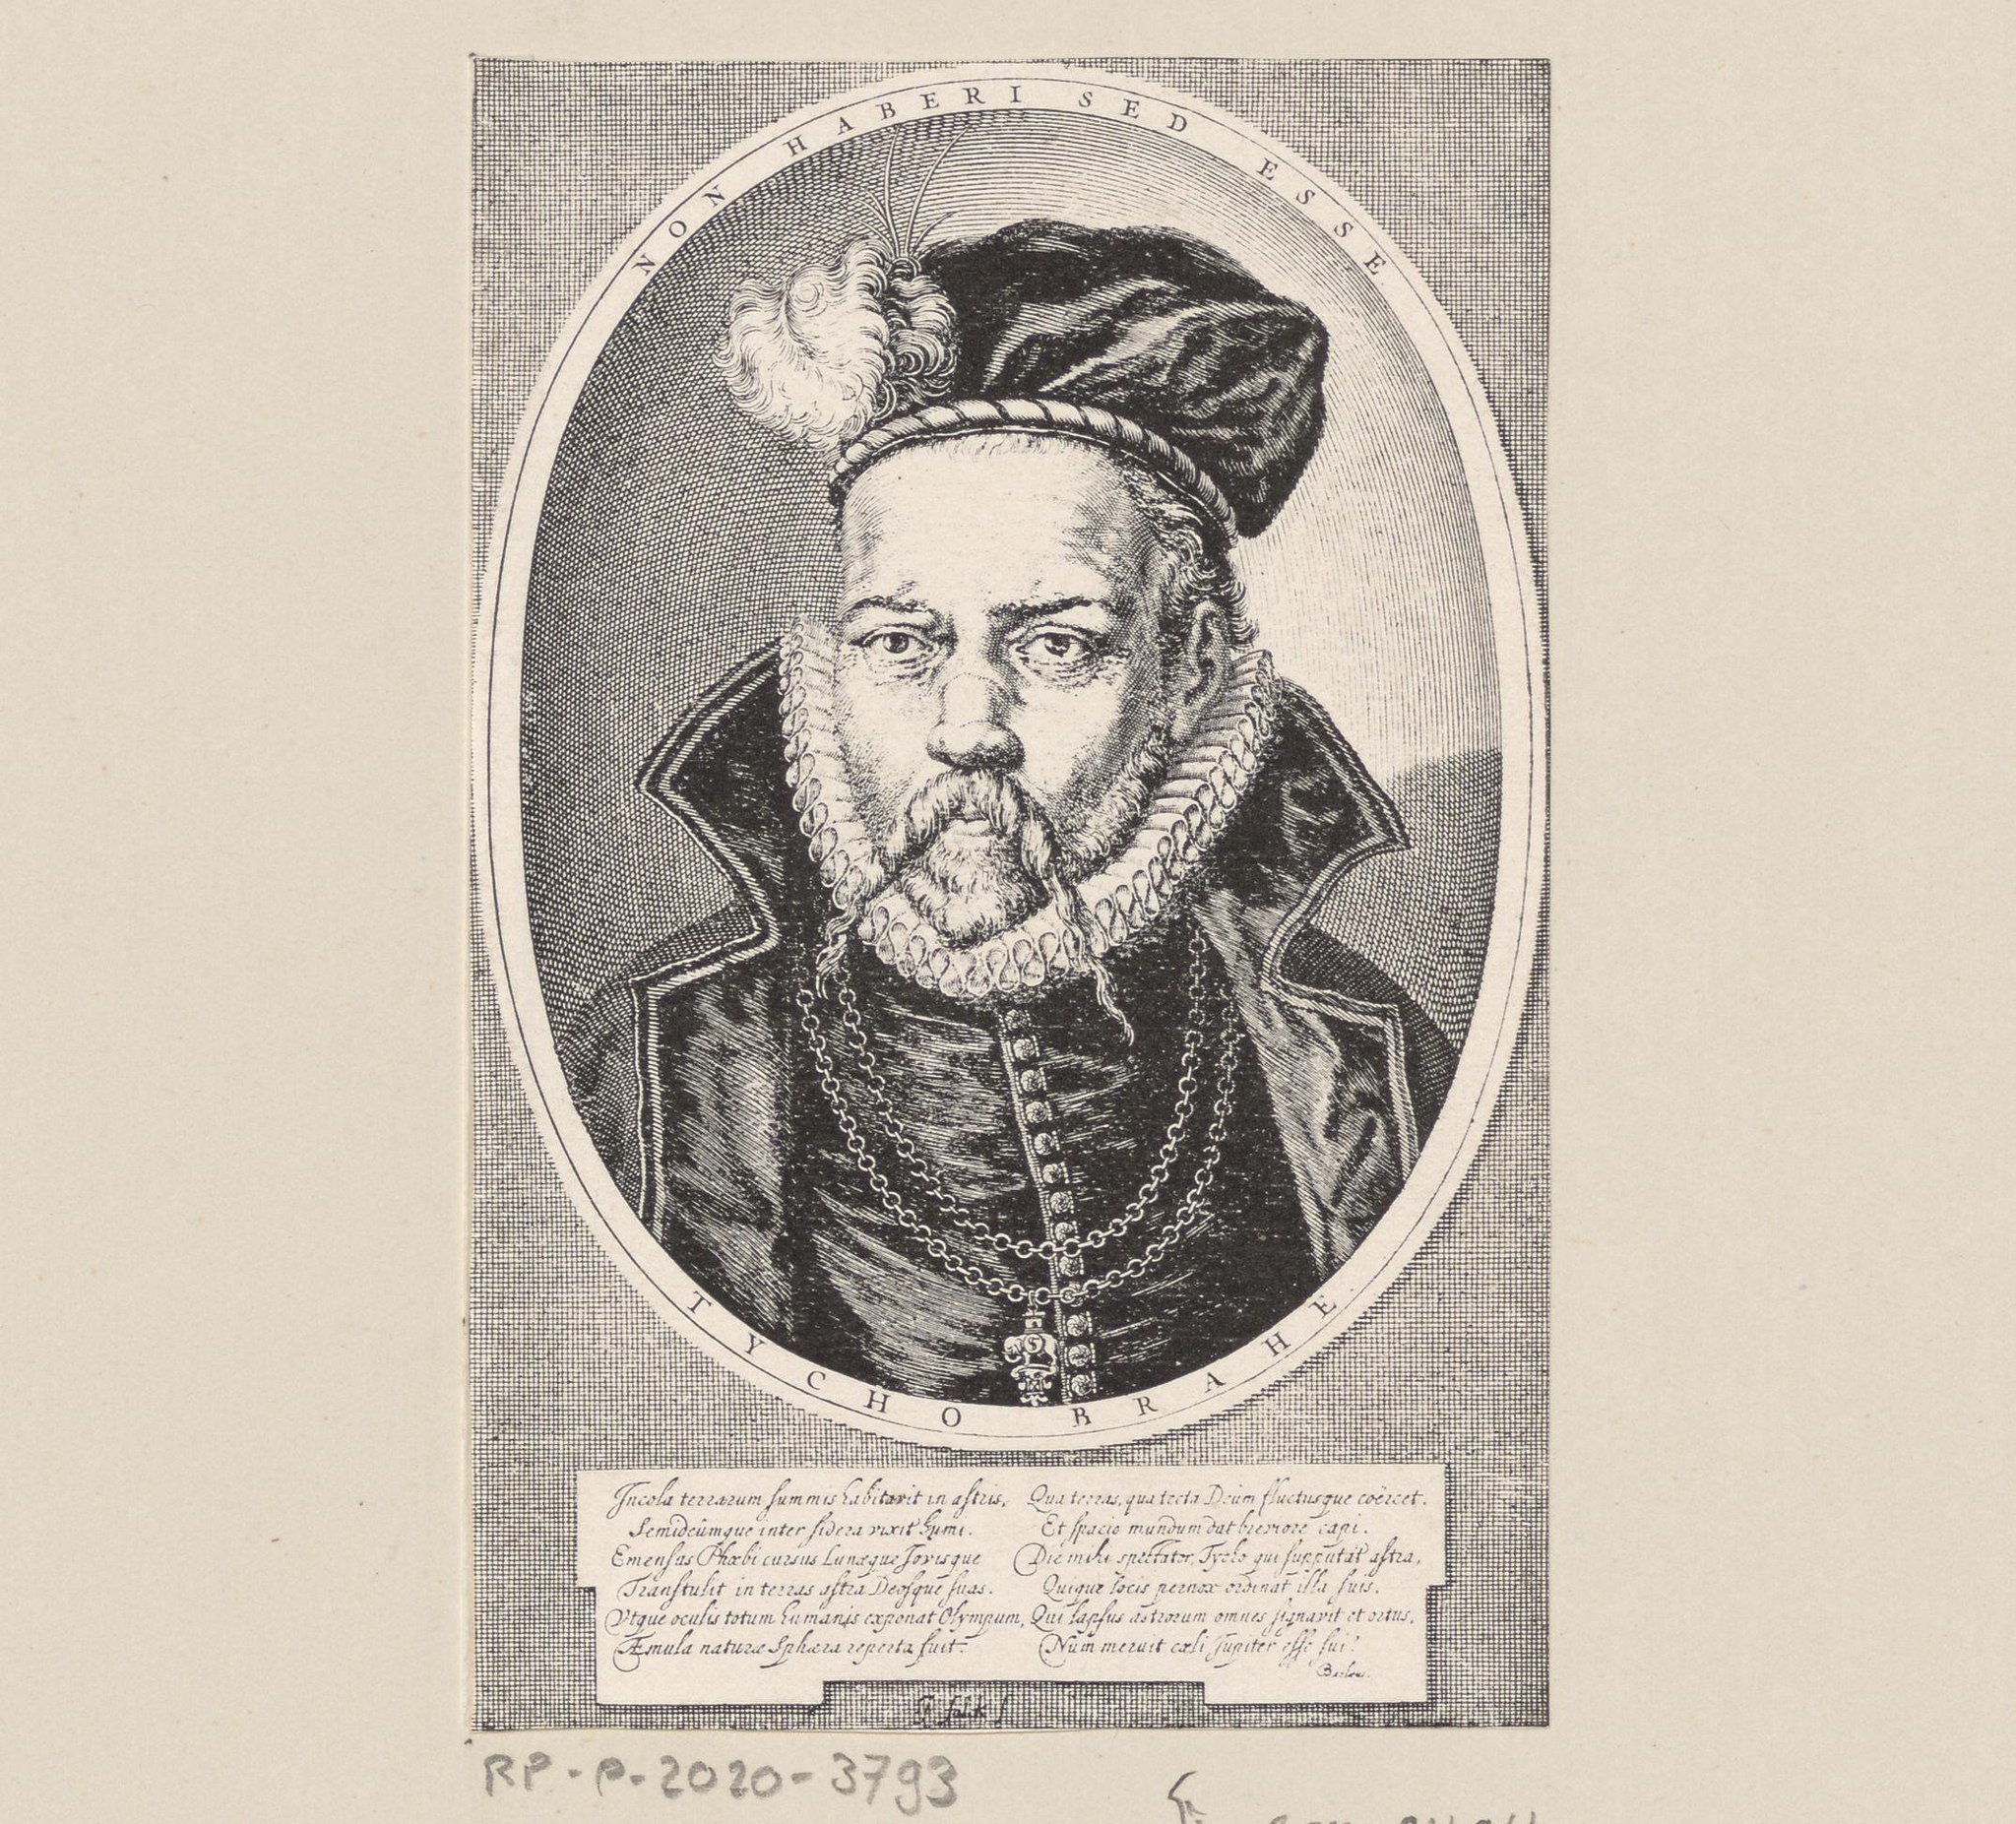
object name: photomechanical print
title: Portret van Tycho Brahe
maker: Anonymous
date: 1925-1975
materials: paper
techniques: printing block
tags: prague, tycho brahe, scholar, philosopher, historical persons